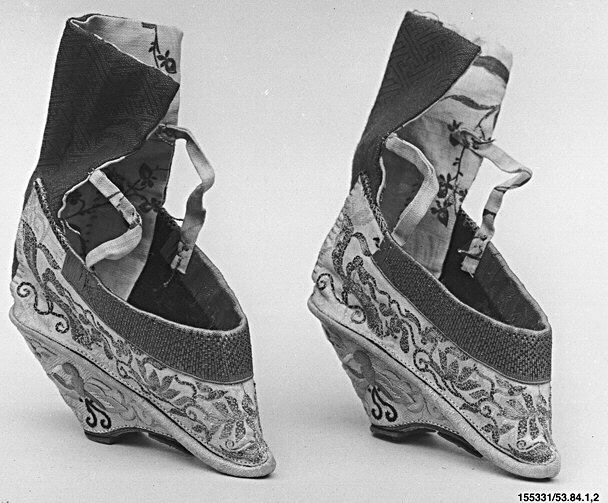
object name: woman's shoe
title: Woman's Shoe for Bound Feet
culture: chinese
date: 1801-2000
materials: leather, linen, metal thread, silk